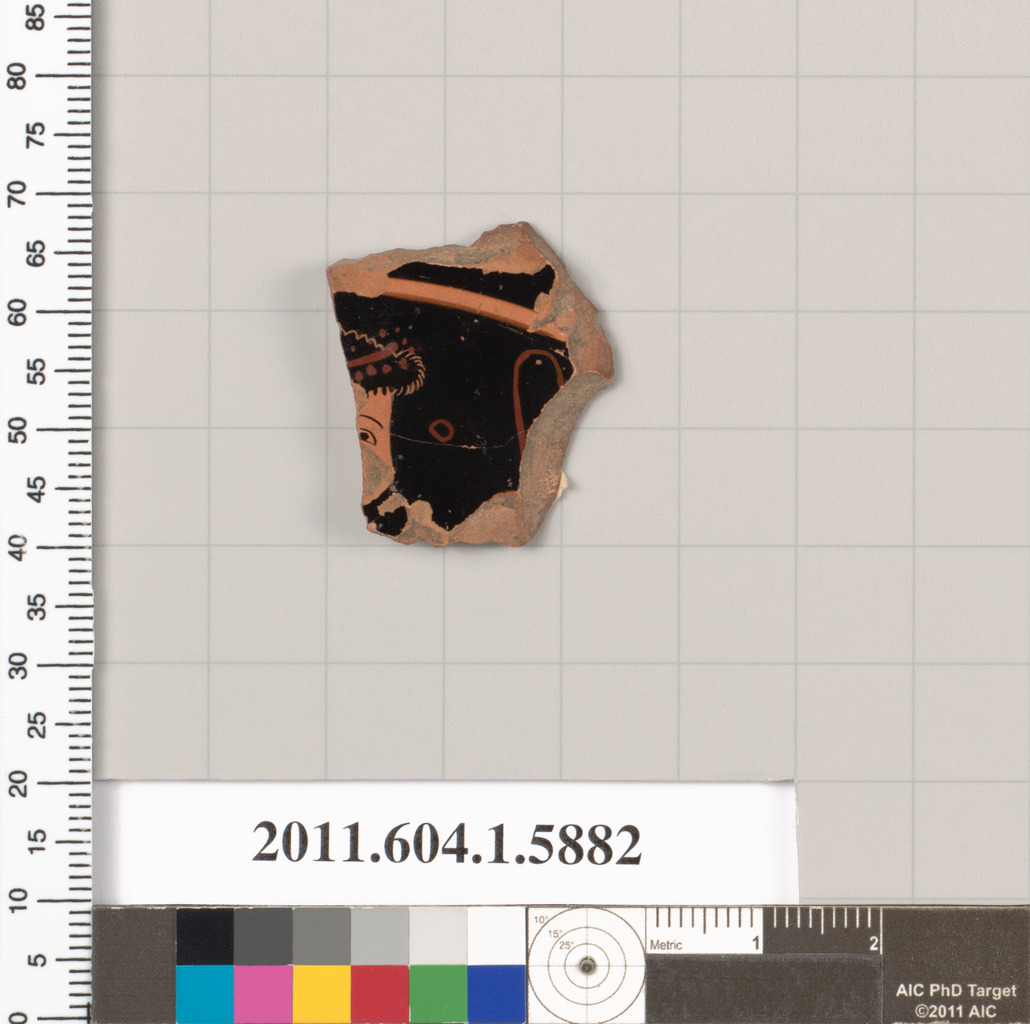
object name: kylix fragment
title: Terracotta fragment of a kylix (drinking cup)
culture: greek, attic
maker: epiktetos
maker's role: artist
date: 520-510 BCE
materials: terracotta